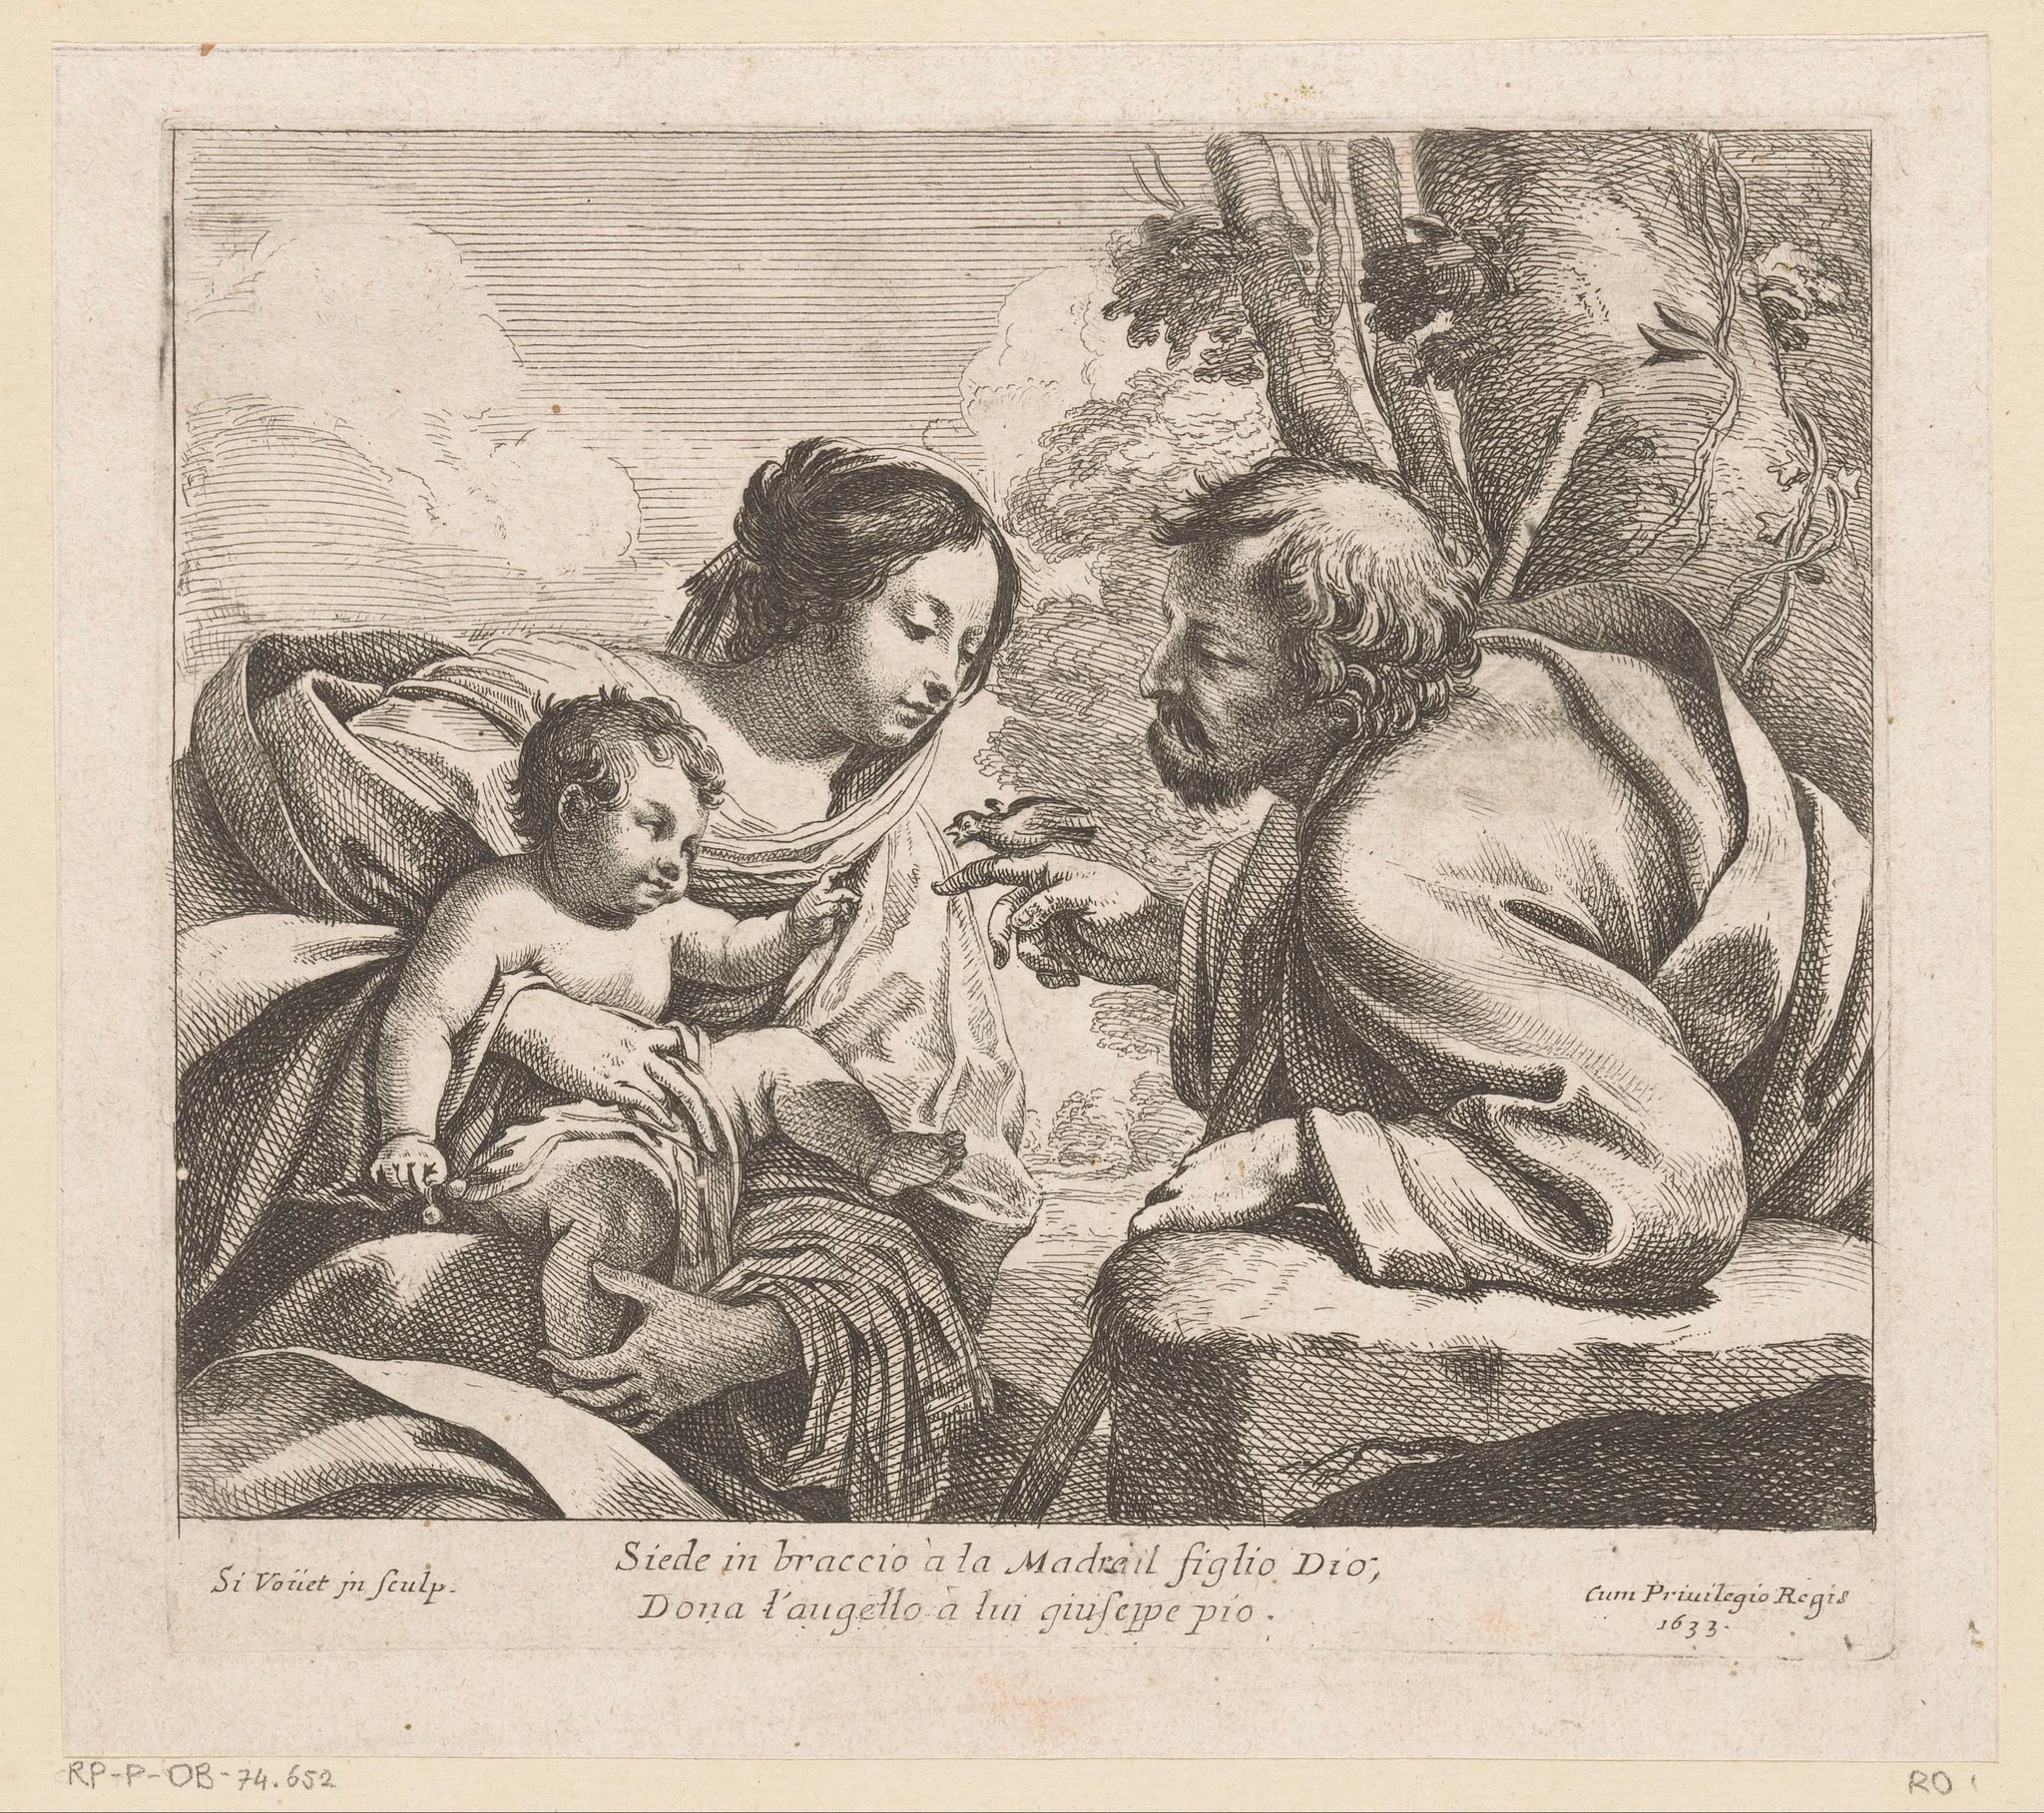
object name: print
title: Heilige Familie met vink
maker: simon vouet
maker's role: draughtsman, print maker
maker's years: 1590-1649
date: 1633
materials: paper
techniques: engraving, etching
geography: france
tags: holy family, and derived representations, song-birds: finch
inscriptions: collector's mark: Lugt 240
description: Dit betreft de enige ets die Vouet zelf vervaardigde.